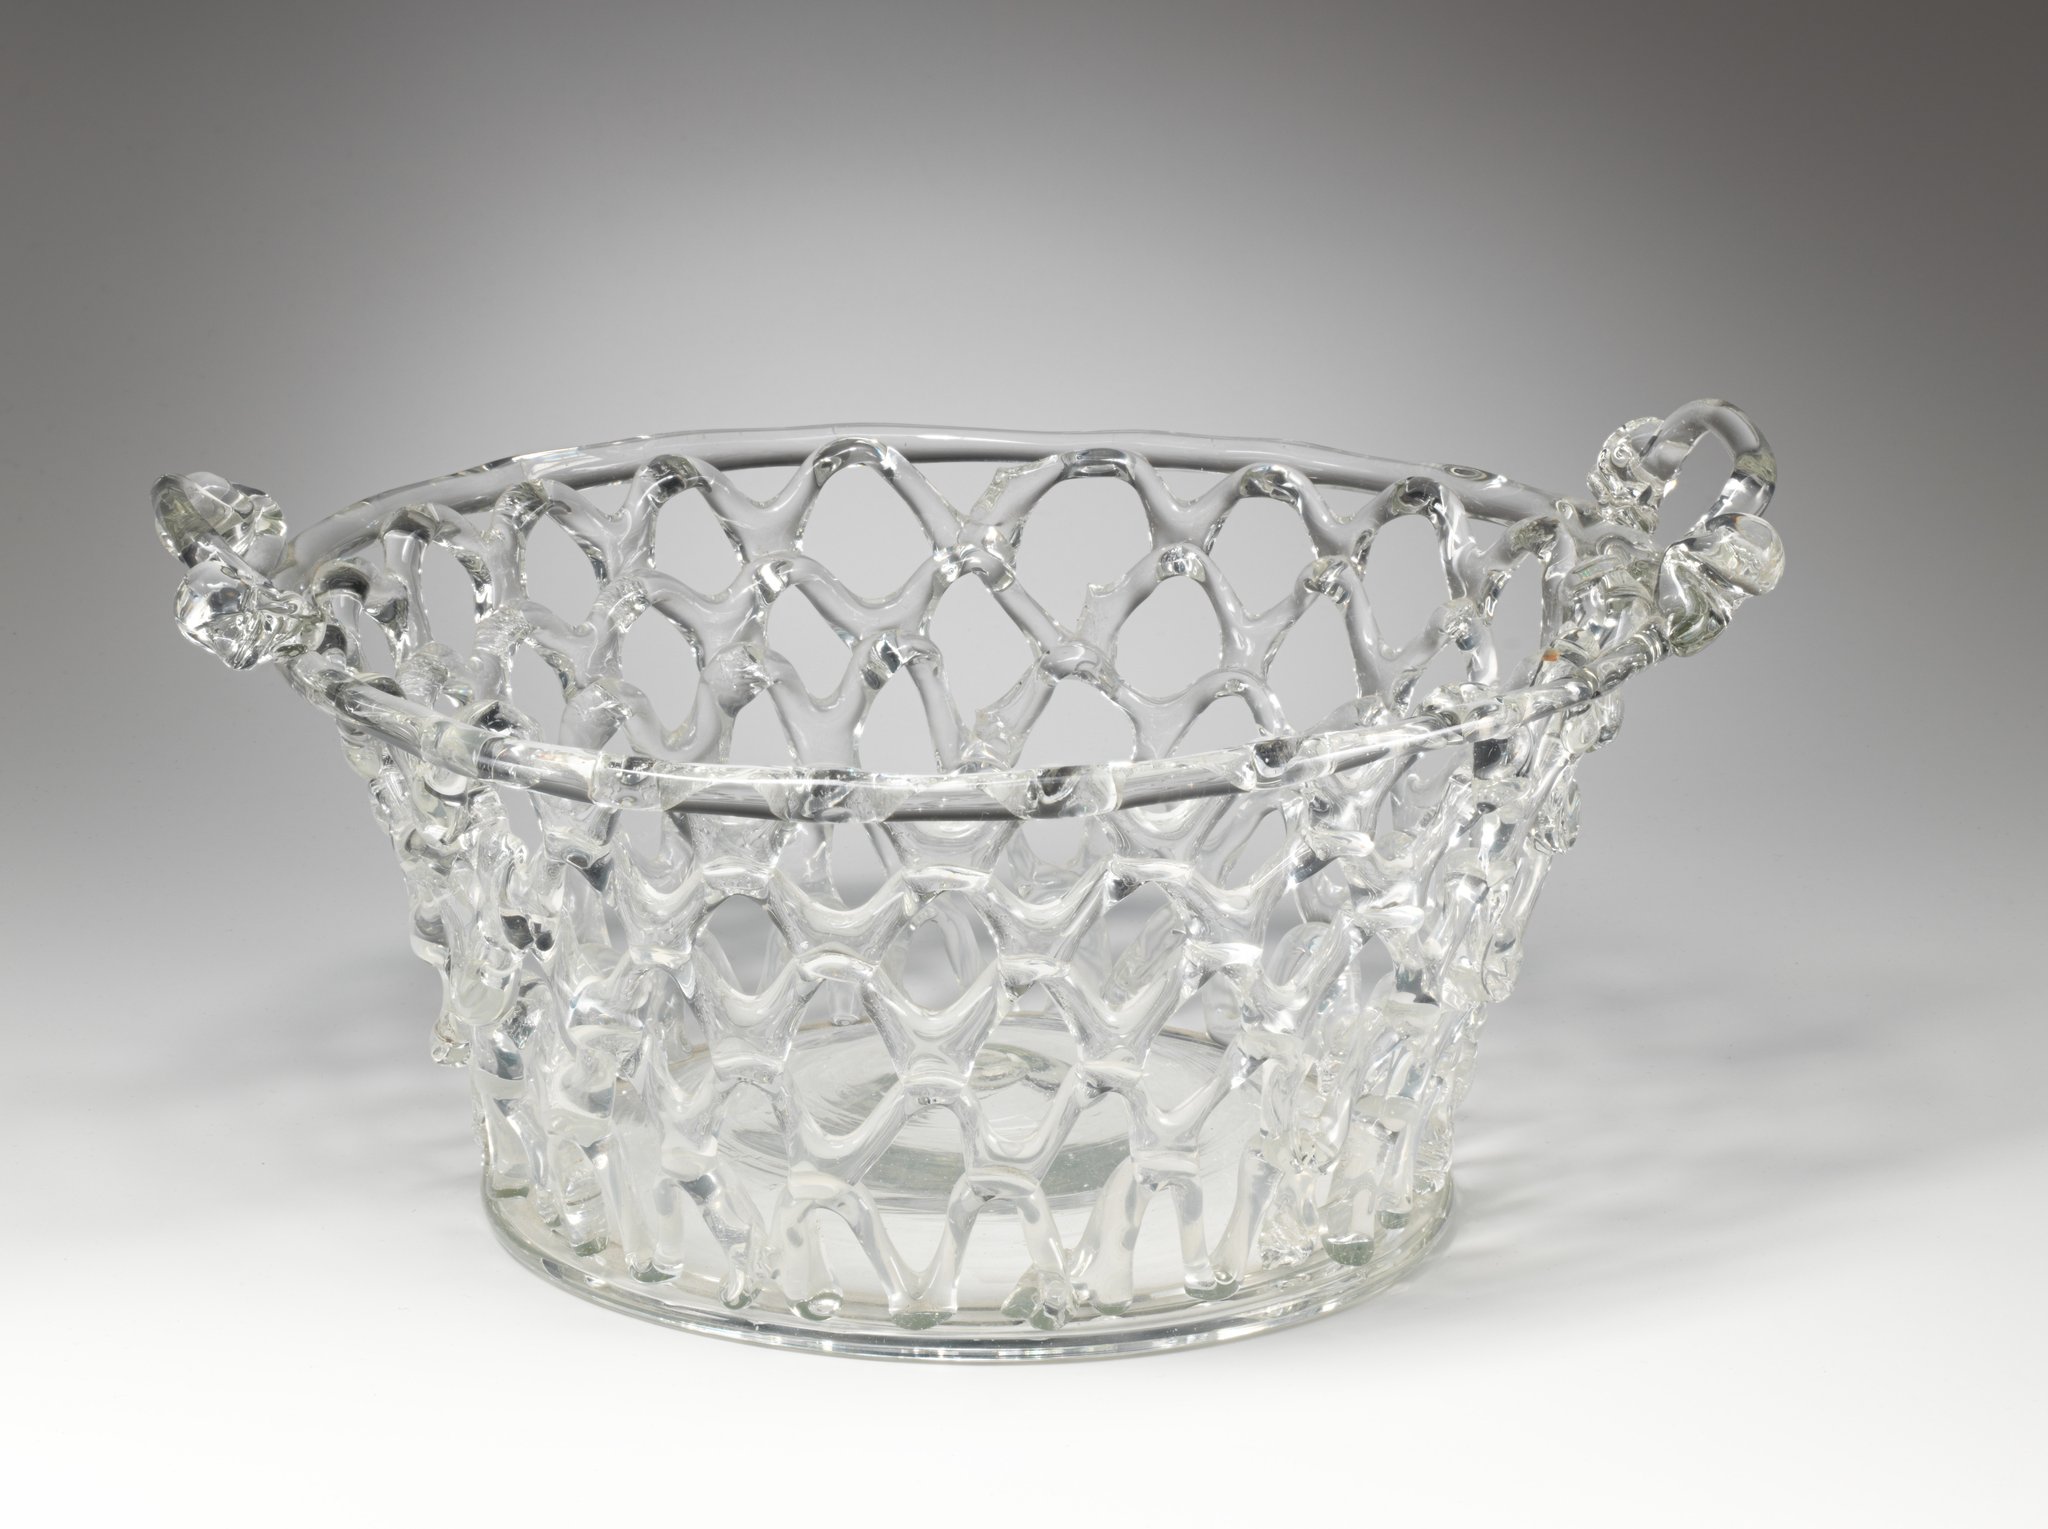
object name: basket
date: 1701-1750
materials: glass